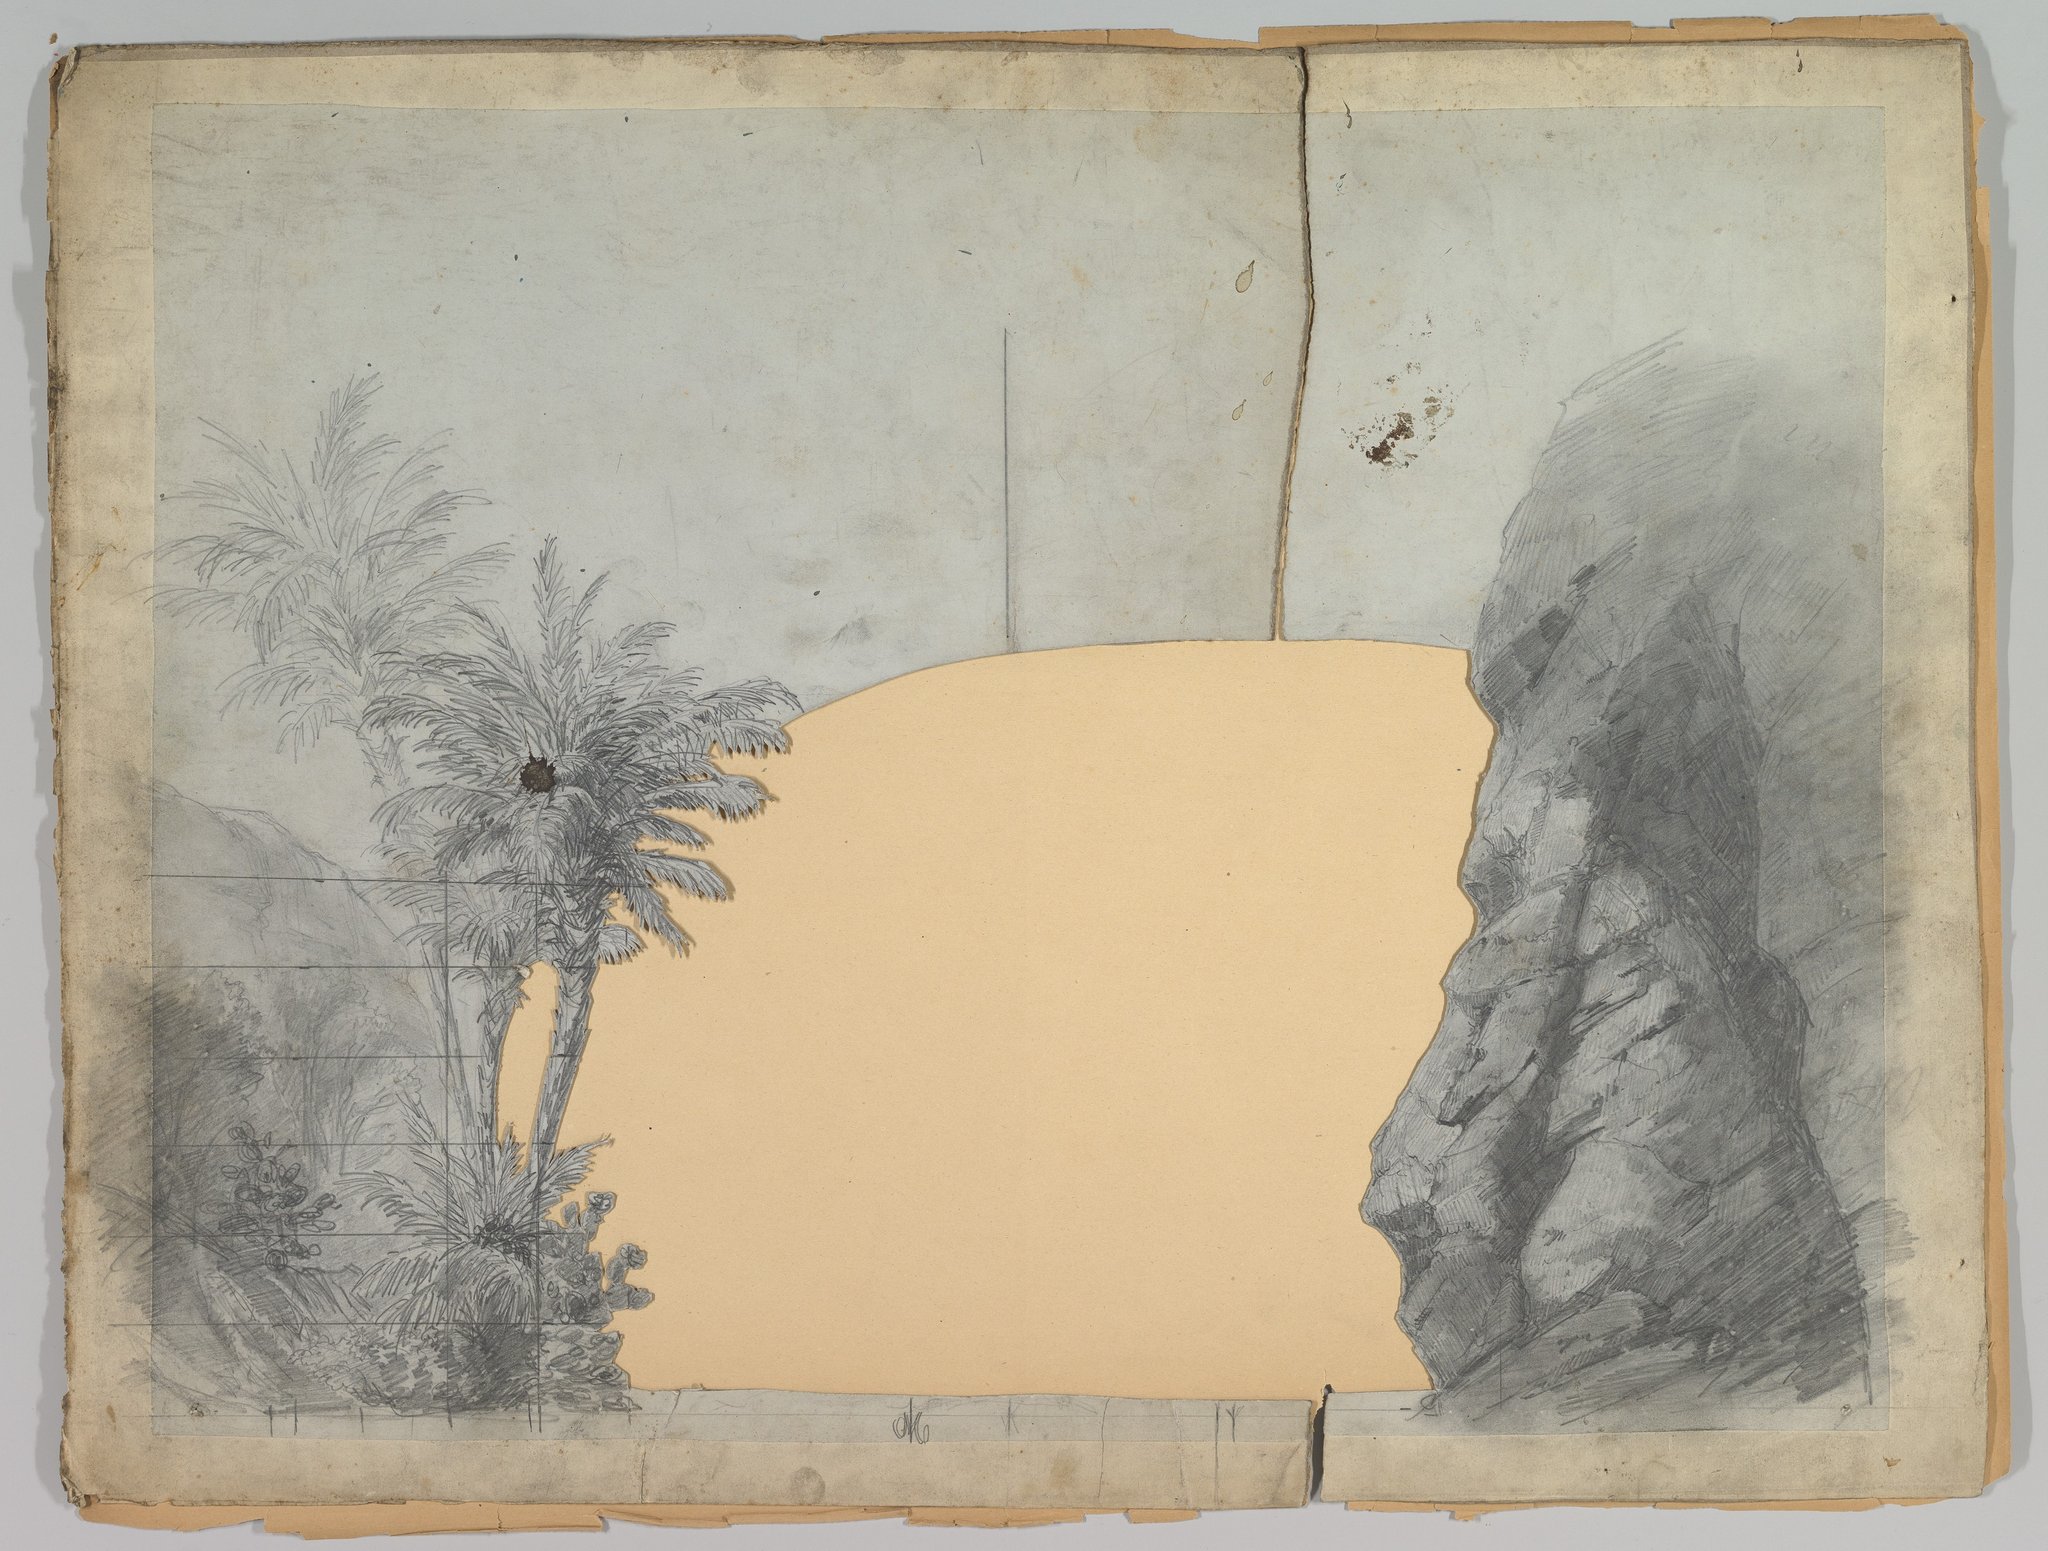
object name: drawing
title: Design for a Stage Set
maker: eugène cicéri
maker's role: artist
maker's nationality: french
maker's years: 1813-1890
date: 1830-1890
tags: trees,stage design